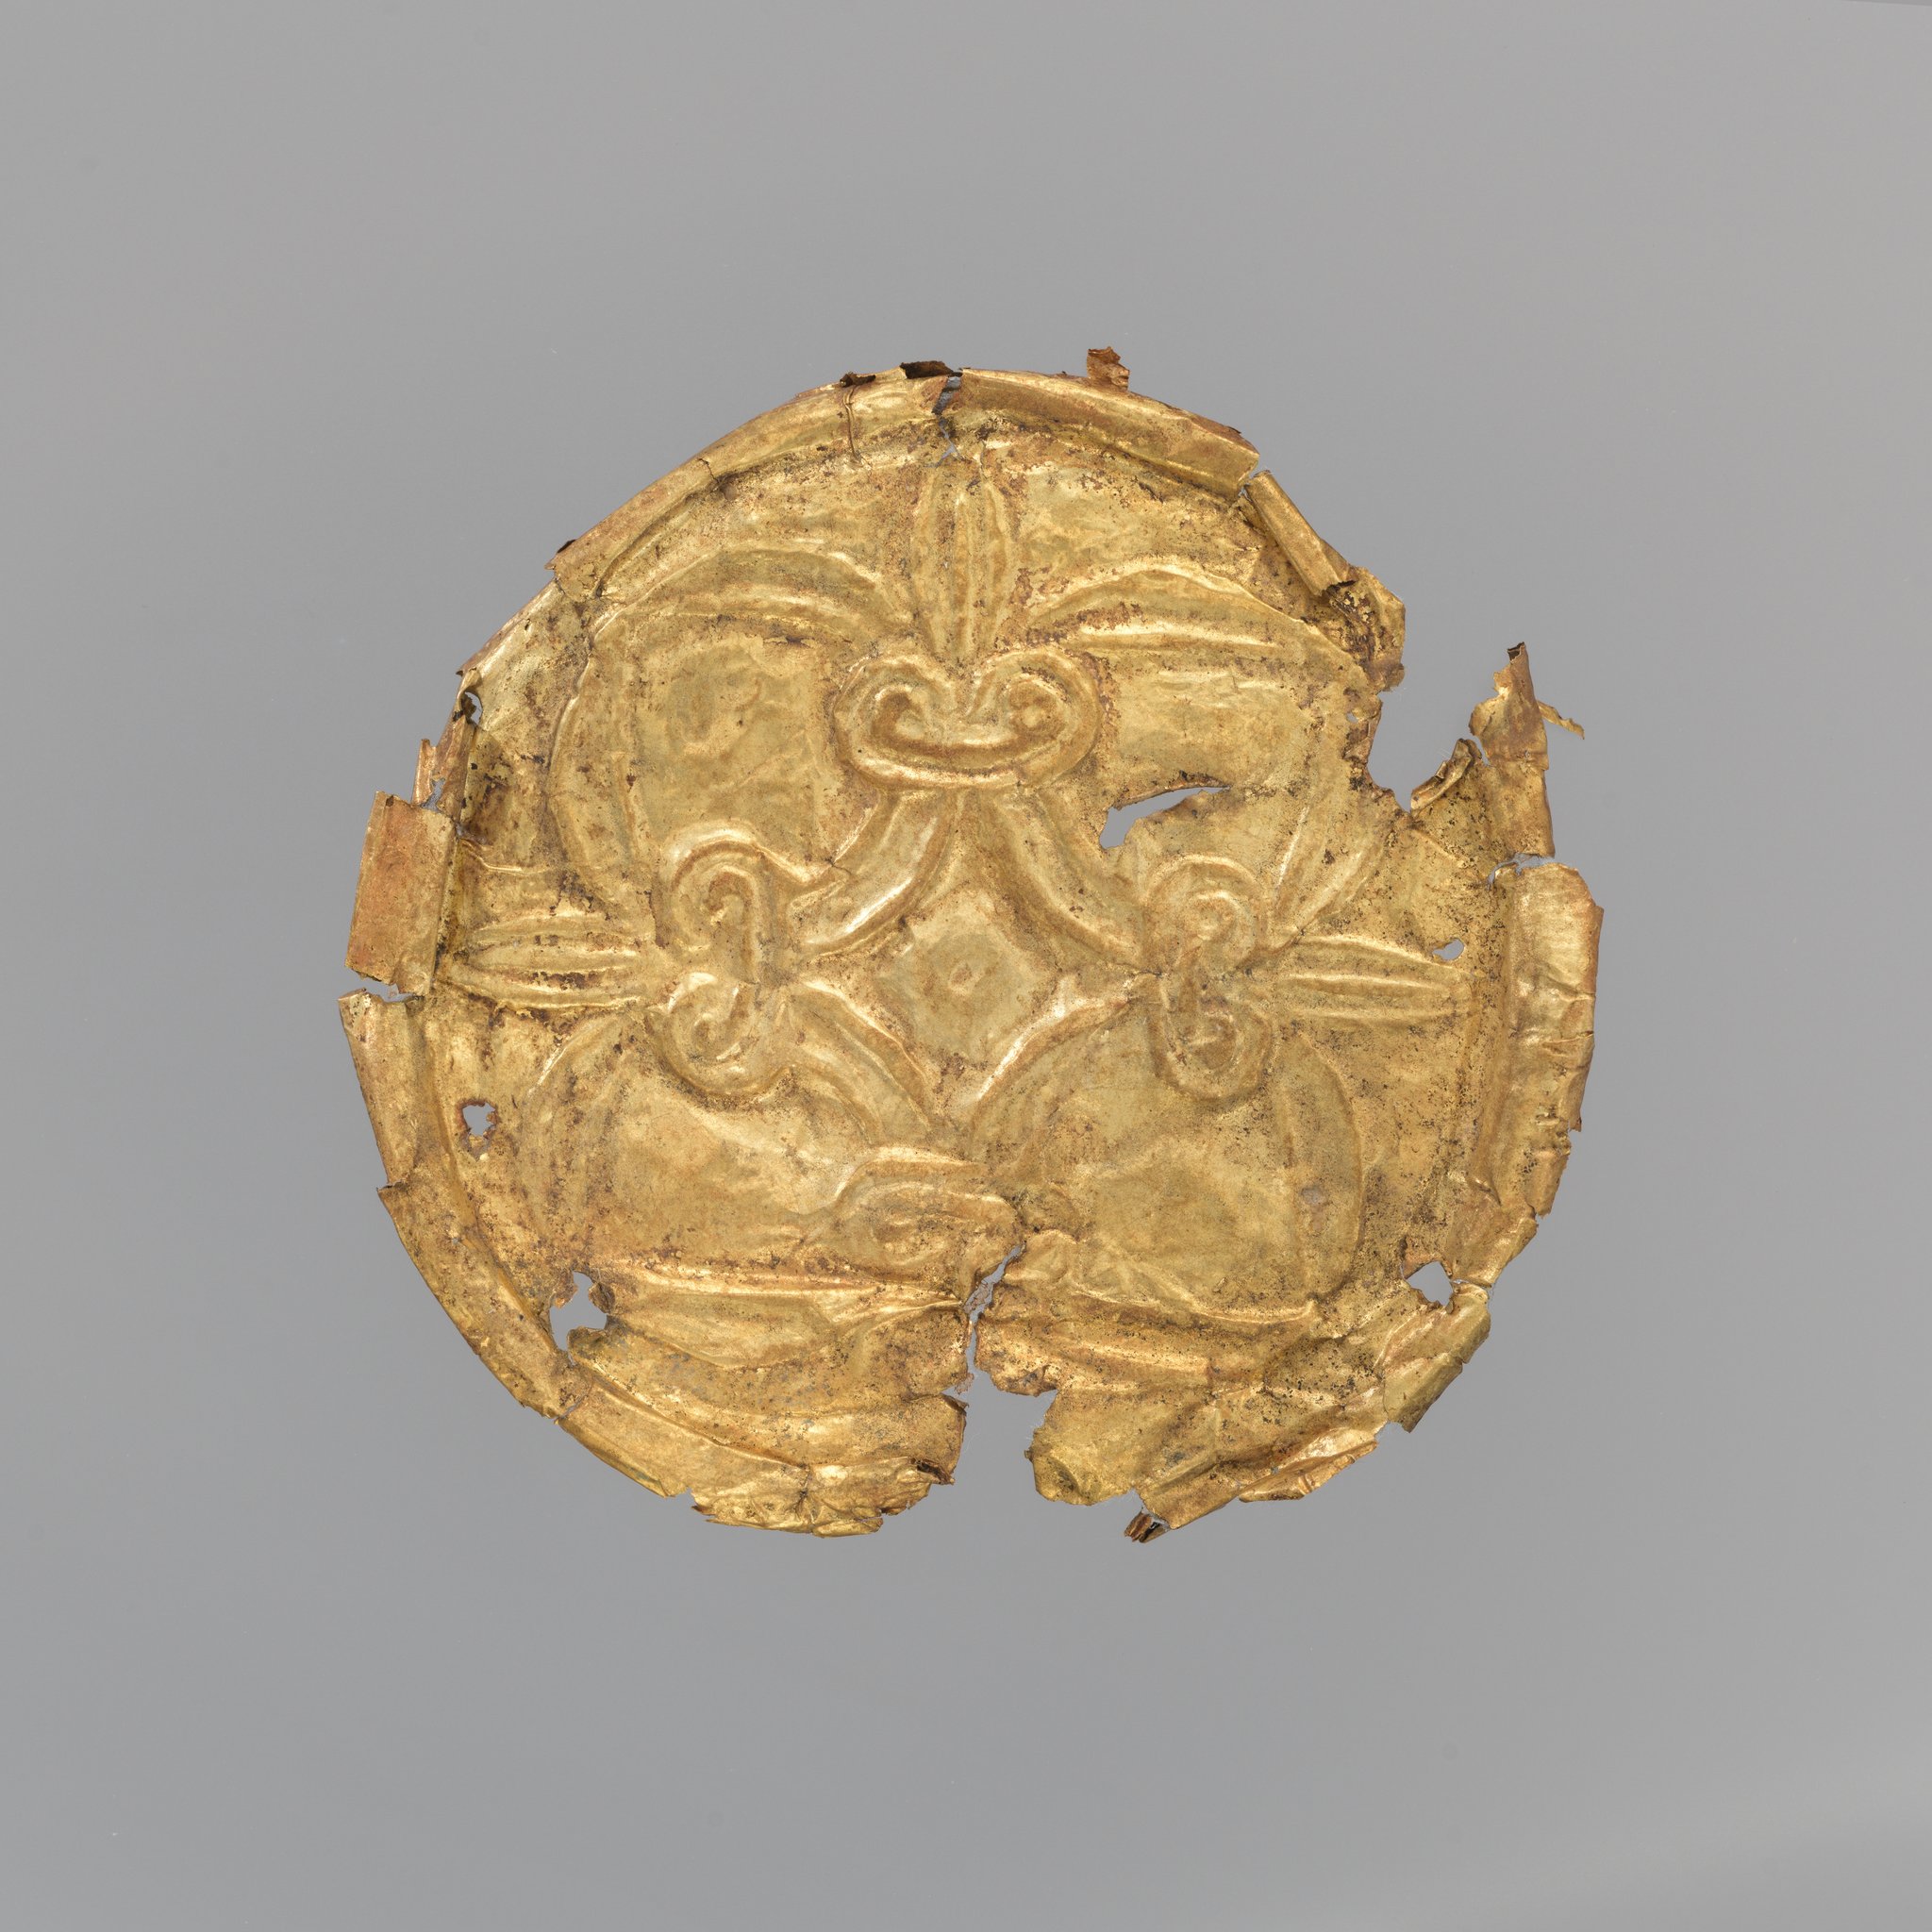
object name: roundel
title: Gold roundel with stamped designs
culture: cypriot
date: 1600-1050 BCE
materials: gold